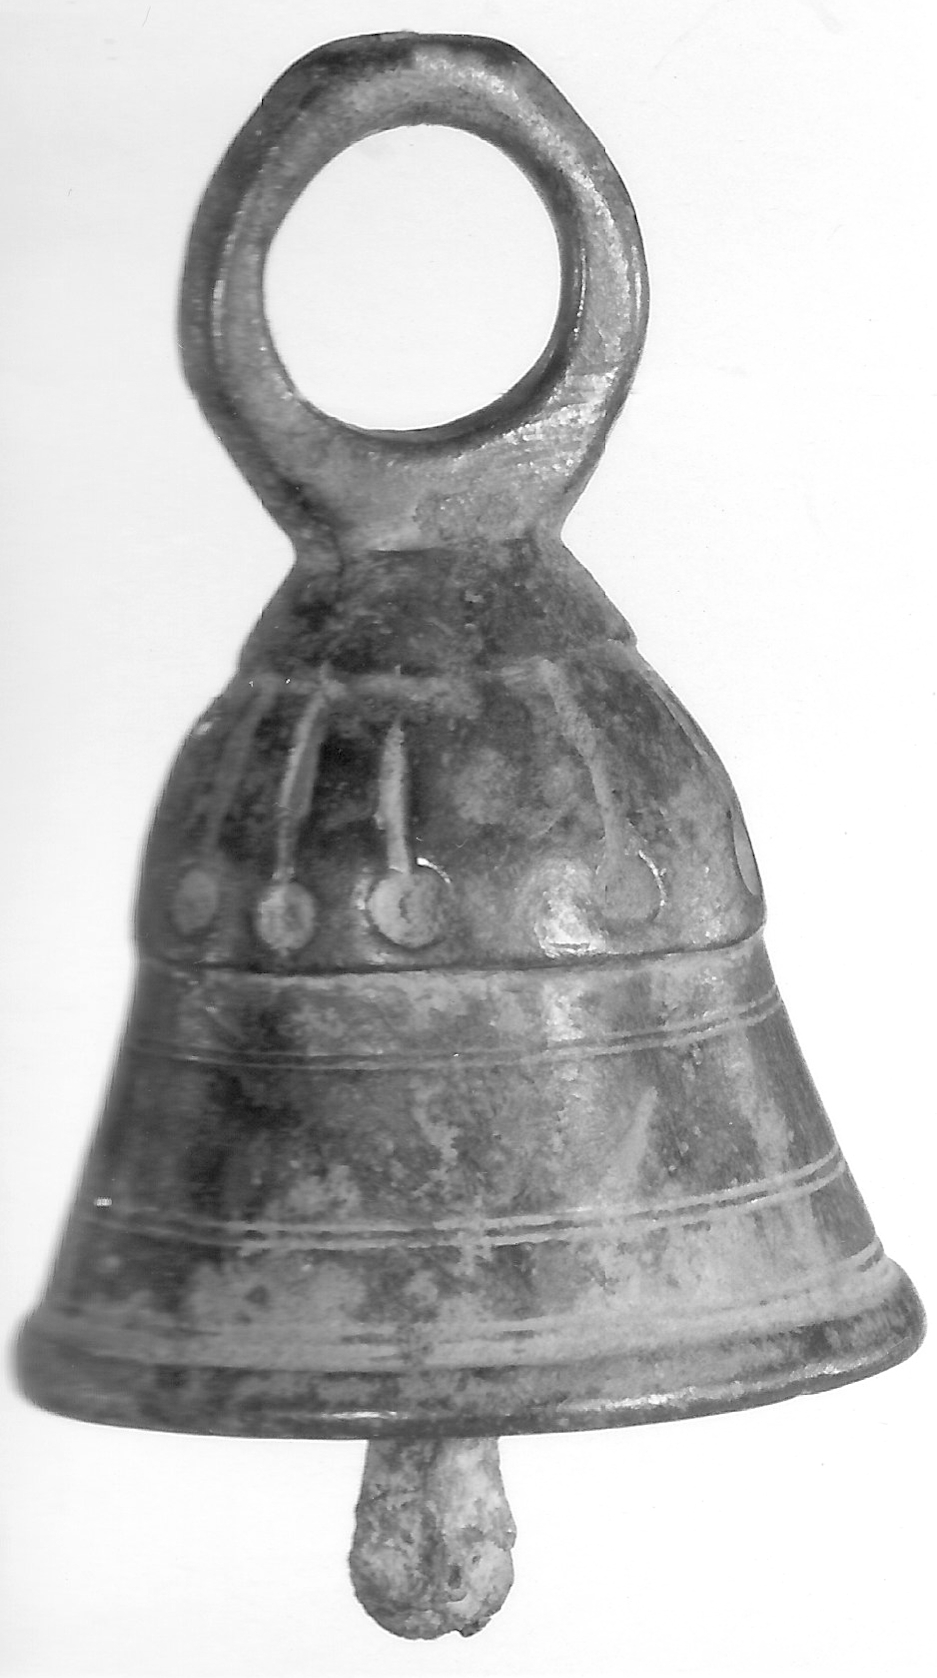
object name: bell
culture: greek or turkish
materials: metal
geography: turkey or greece